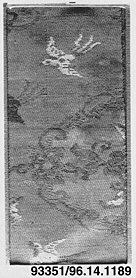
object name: piece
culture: japanese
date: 1701-1900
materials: silk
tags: birds